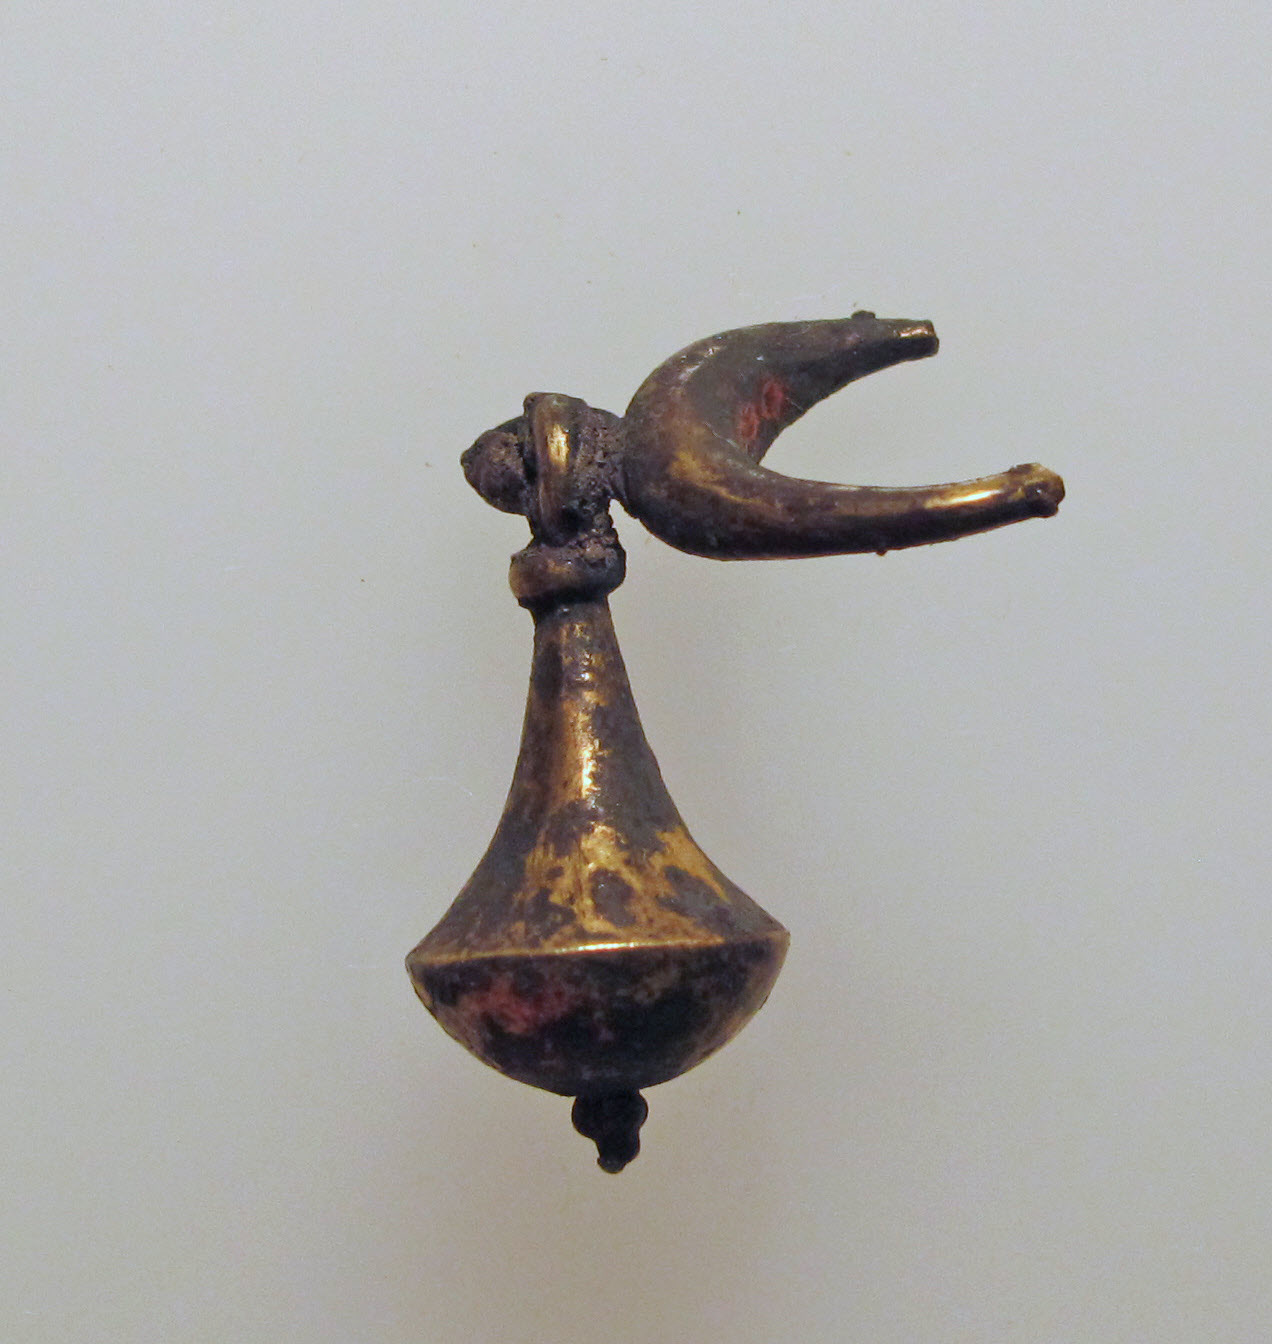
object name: earring with nail head pendant, 6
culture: cypriot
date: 3900 BCE-100 CE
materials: silver